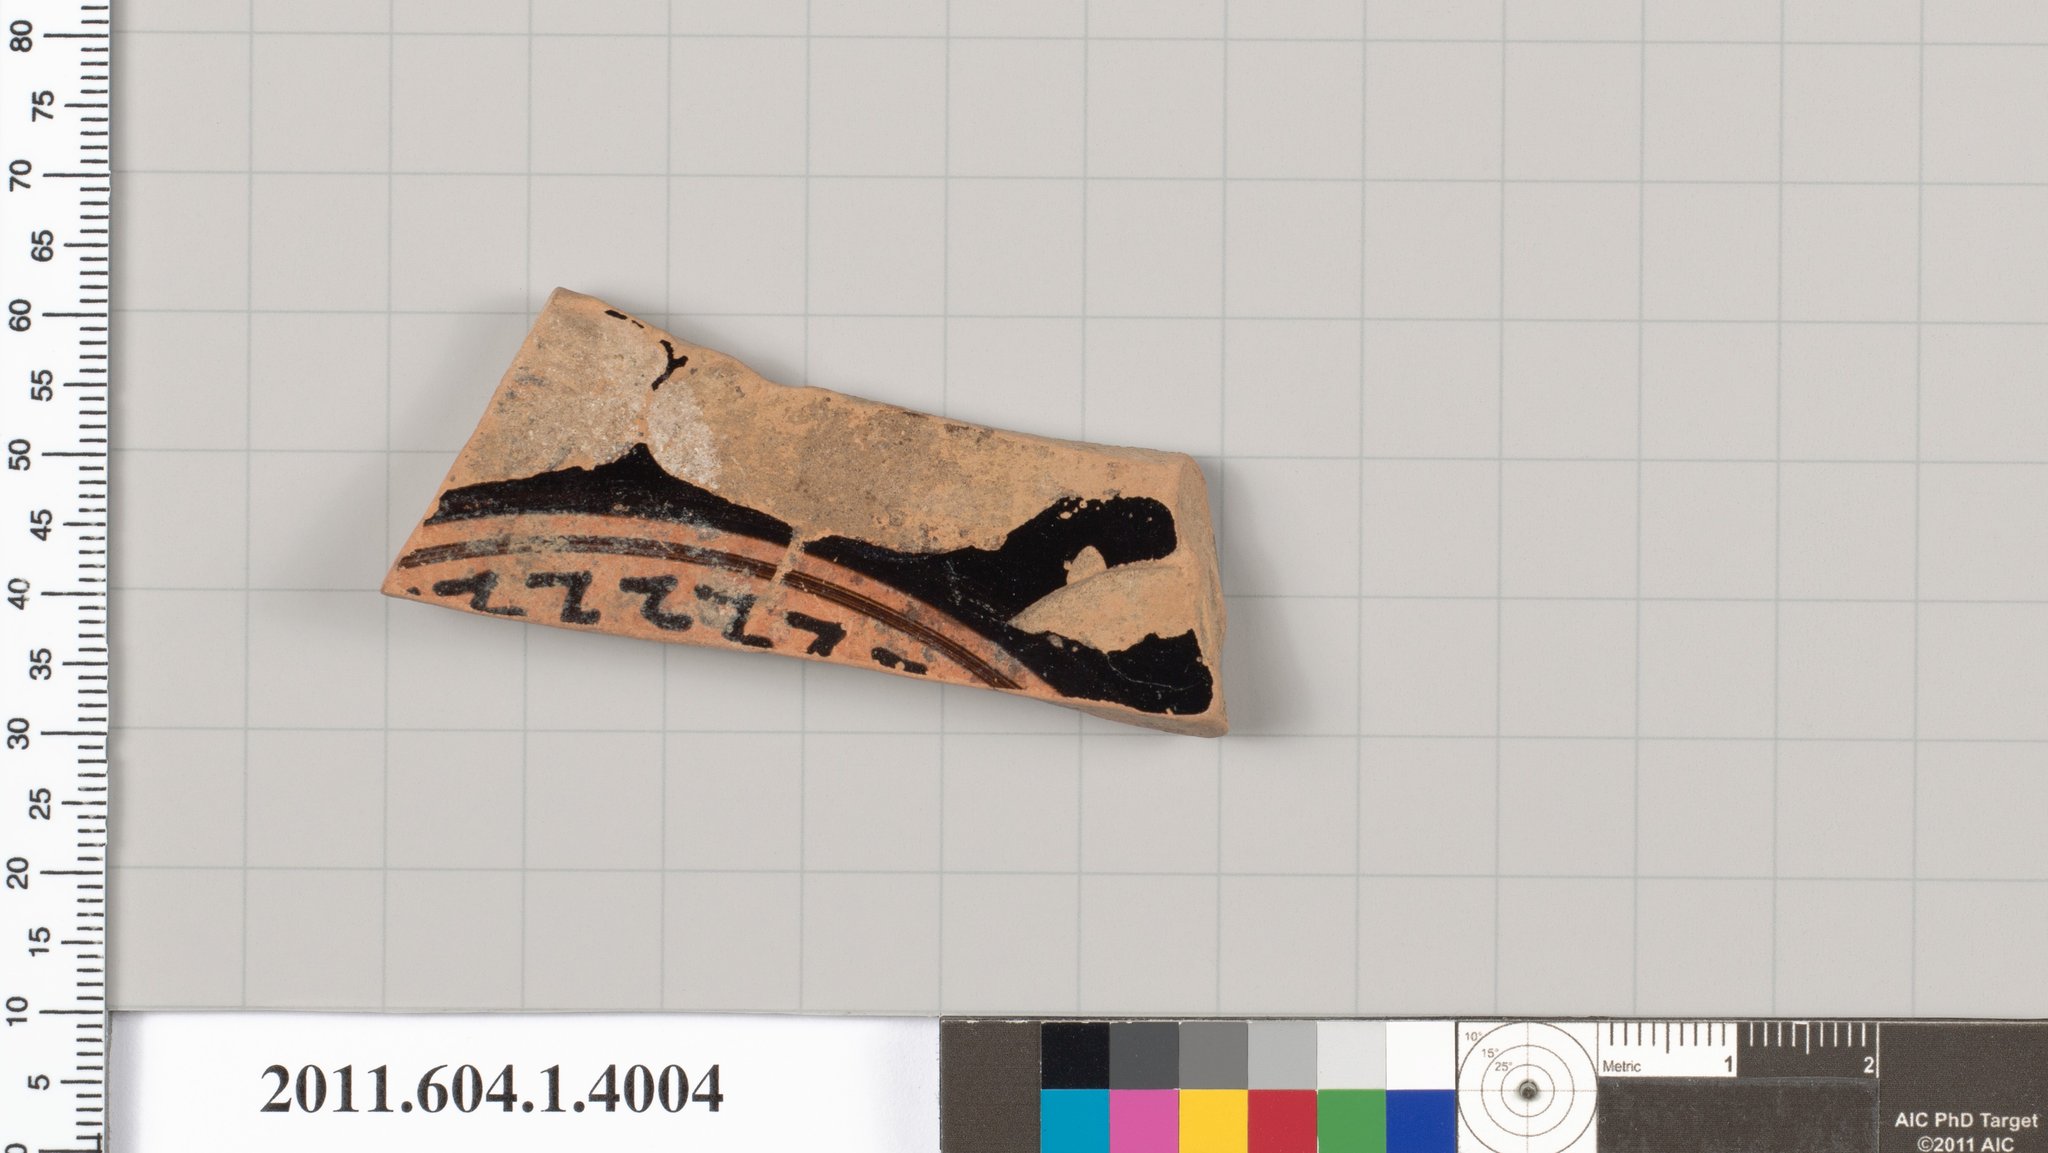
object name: kylix fragment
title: Terracotta fragment of a kylix (drinking cup)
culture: greek, attic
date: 475-451 BCE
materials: terracotta